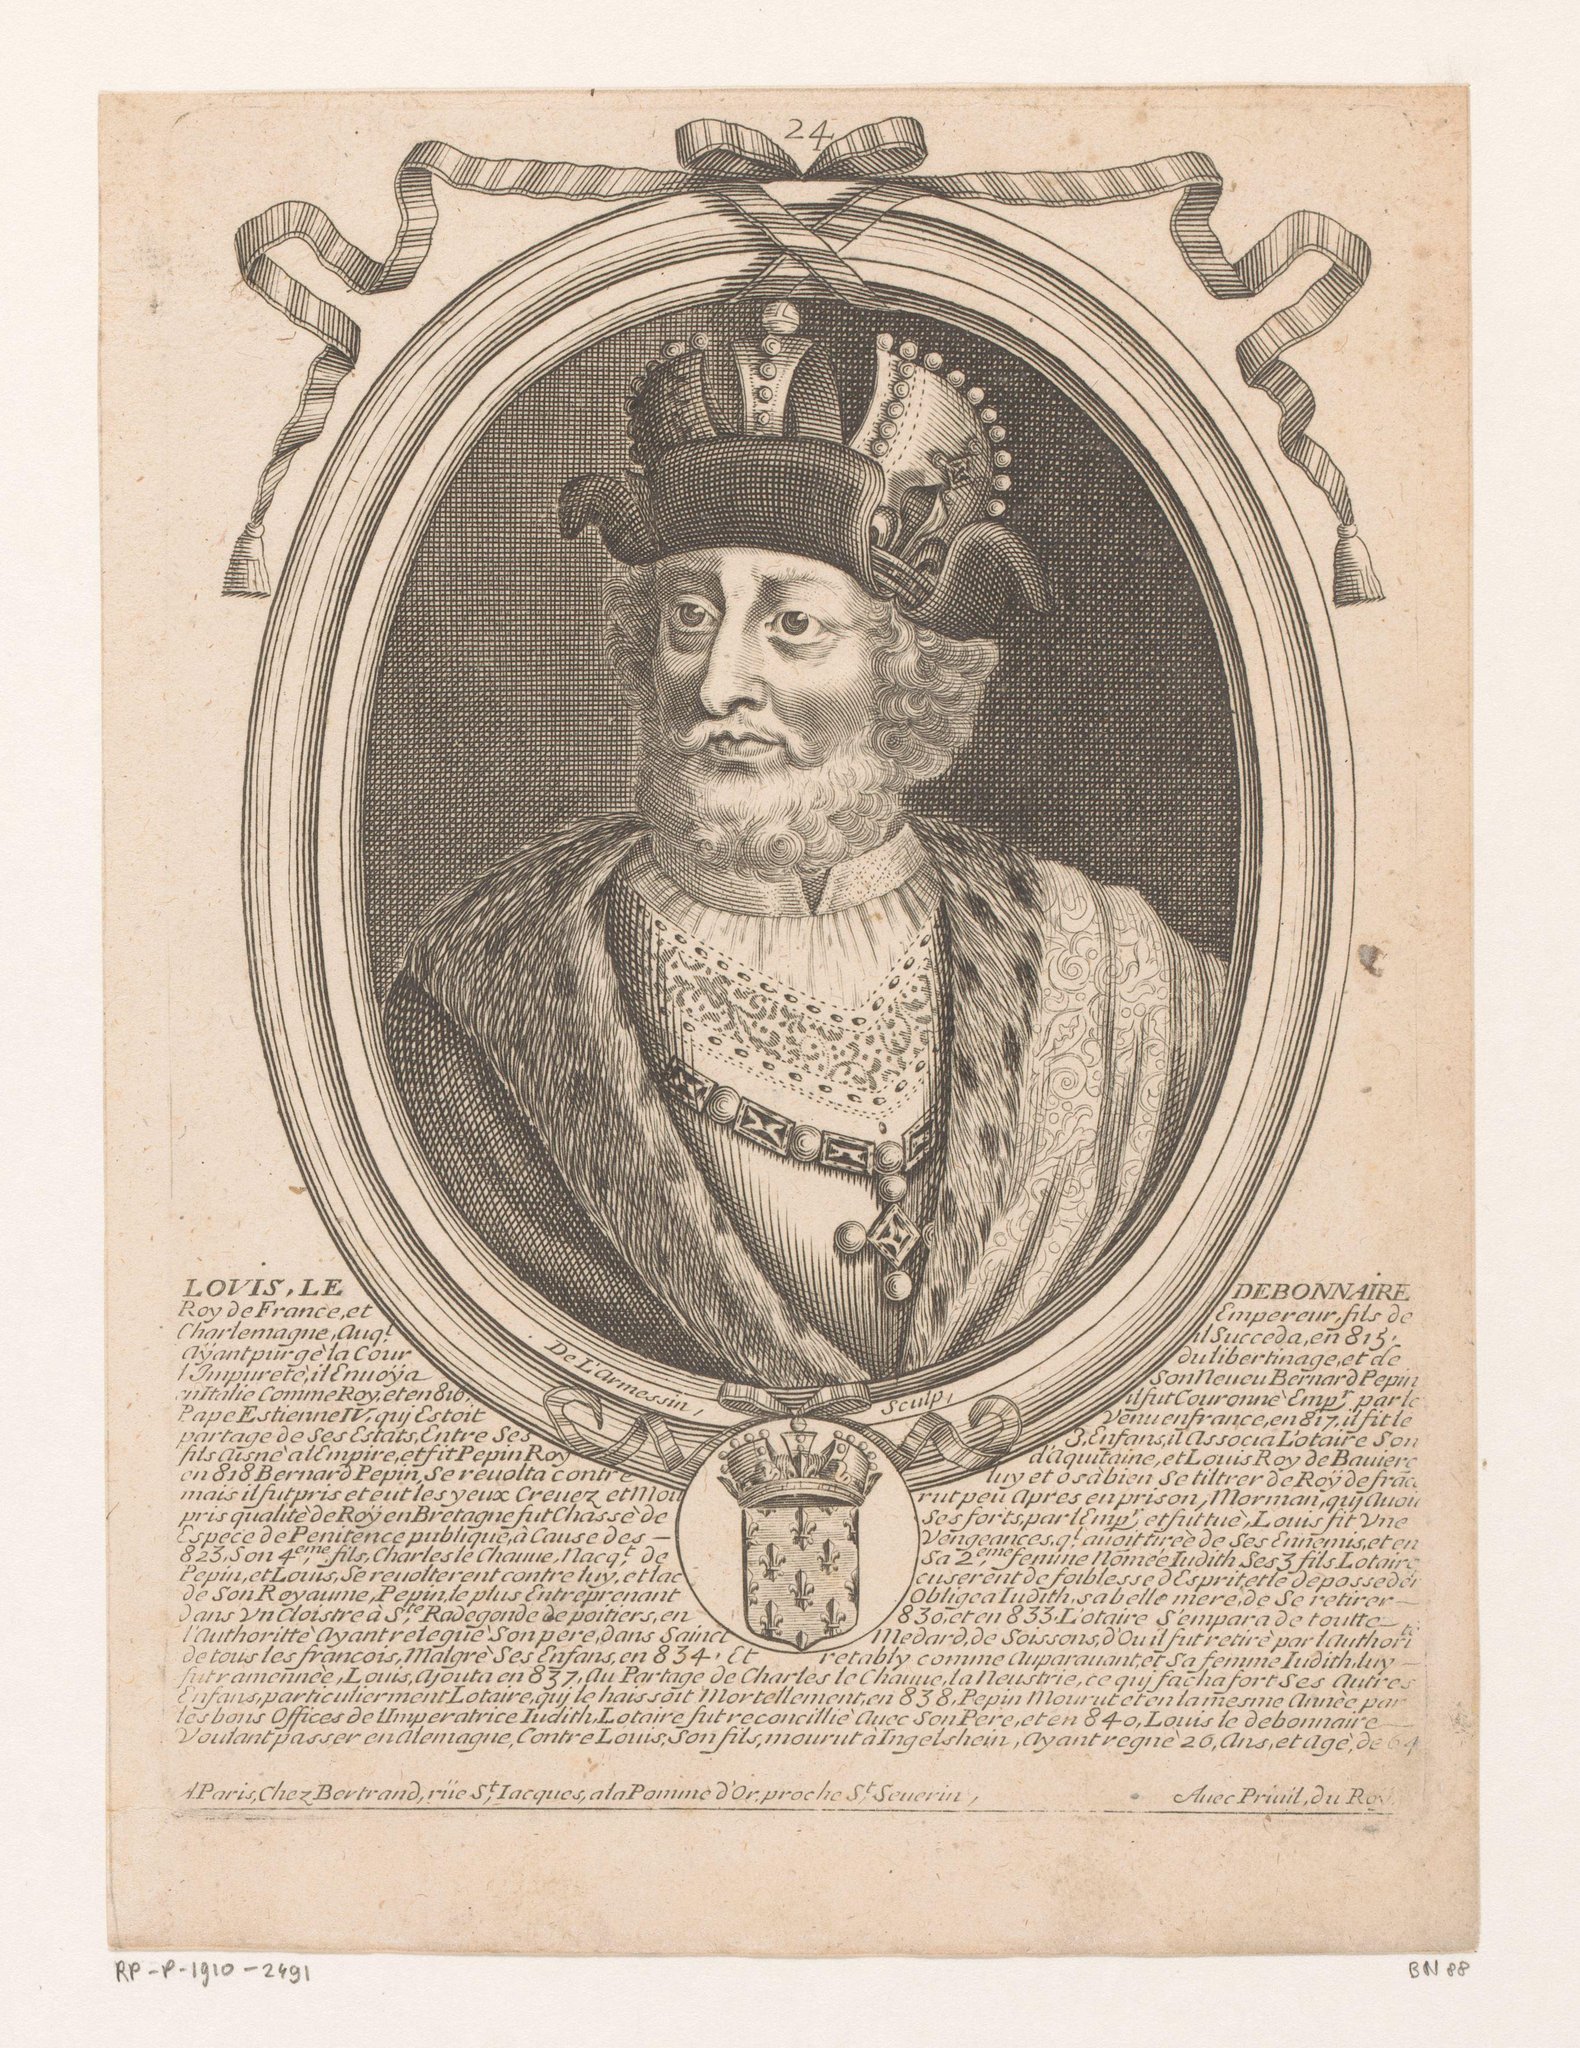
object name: print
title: Louis Le De Bonnaire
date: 1642-1678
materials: paper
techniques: engraving, etching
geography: france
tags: france, historical persons, king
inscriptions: collector's mark: Lugt 2228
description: Maakt deel uit van een grootschalige serie met portretten van prominente figuren. Binnen de serie bevindt zich een sectie getiteld 'Les Augustes Représentations De tous les Roys De France depuis Pharamond Iusqu'à Louys XIIII'. De serie werd respectievelijk uitgegeven door Pierre Bertrand, door zijn weduwe en door De Larmessin zelf.